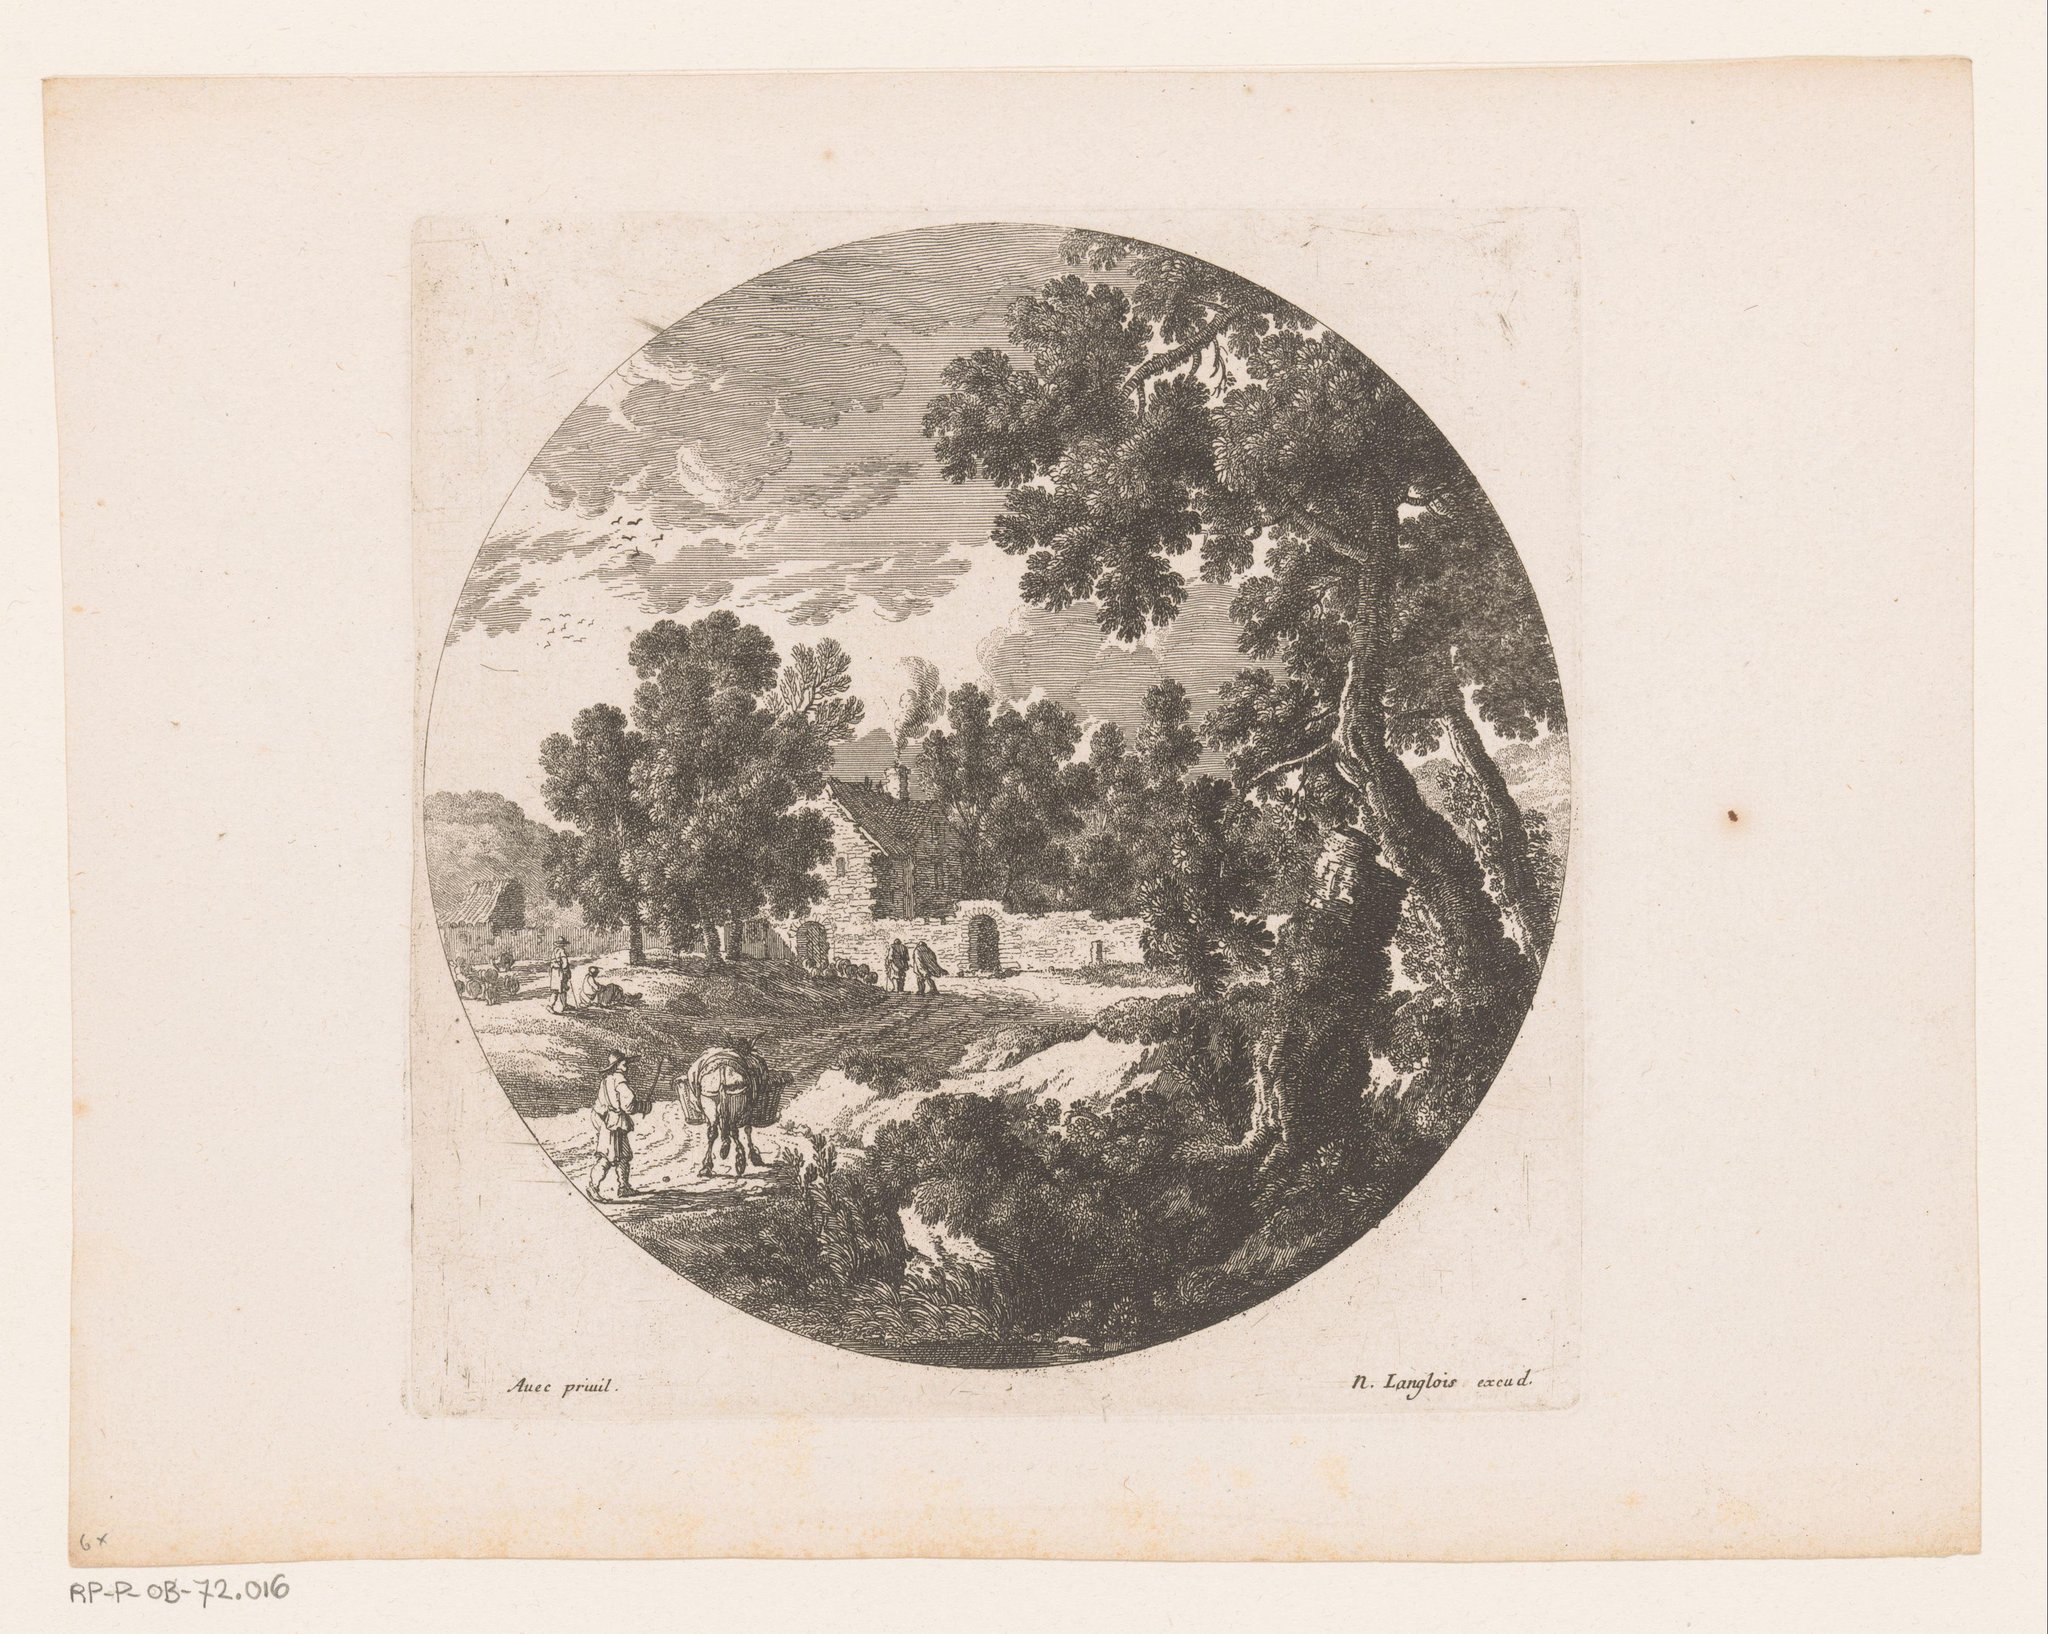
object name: print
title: Landschap met herders en vee bij huis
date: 1650-1695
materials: paper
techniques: etching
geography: france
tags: farm or solitary house in landscape (+ city(-scape) with figures, staffage), herd, flock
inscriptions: collector's mark: Lugt 240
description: Prenten met het signatuur 'Perelle' kunnen zowel door vader Gabriel als door zonen Nicolas en Adam gemaakt zijn.